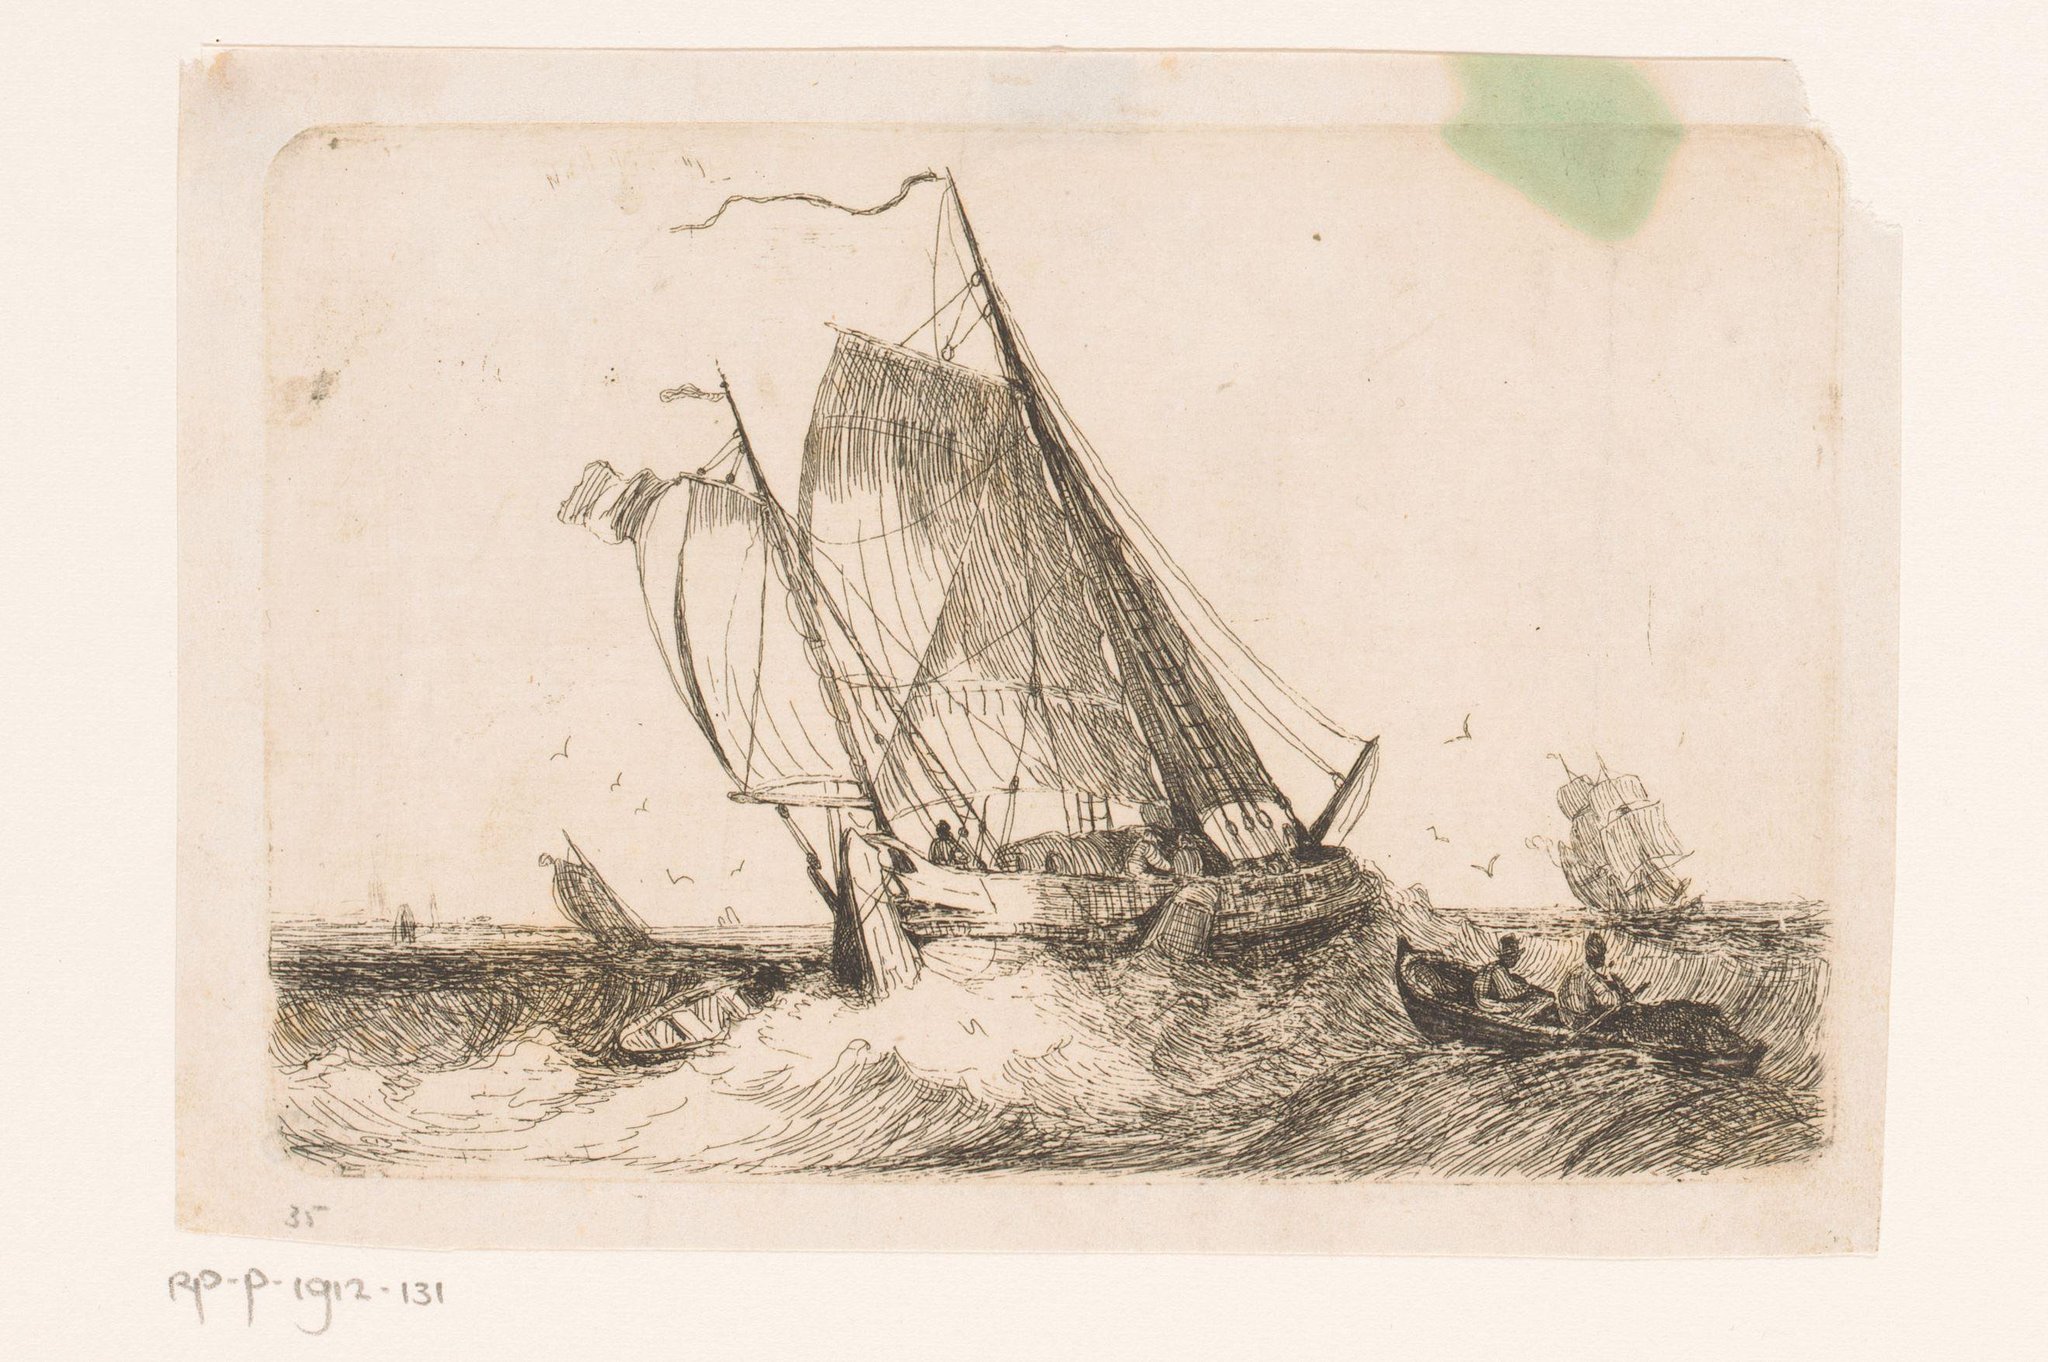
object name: print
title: Zeilschepen en een roeiboot op onrustige zee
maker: egidius linnig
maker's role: draughtsman, print maker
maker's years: 1821-1860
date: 1842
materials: paper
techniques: etching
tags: sailing-ship, sailing-boat, rowing-boat, canoe, etc.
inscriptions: collector's mark: Lugt 1485, collector's mark: Lugt 2228